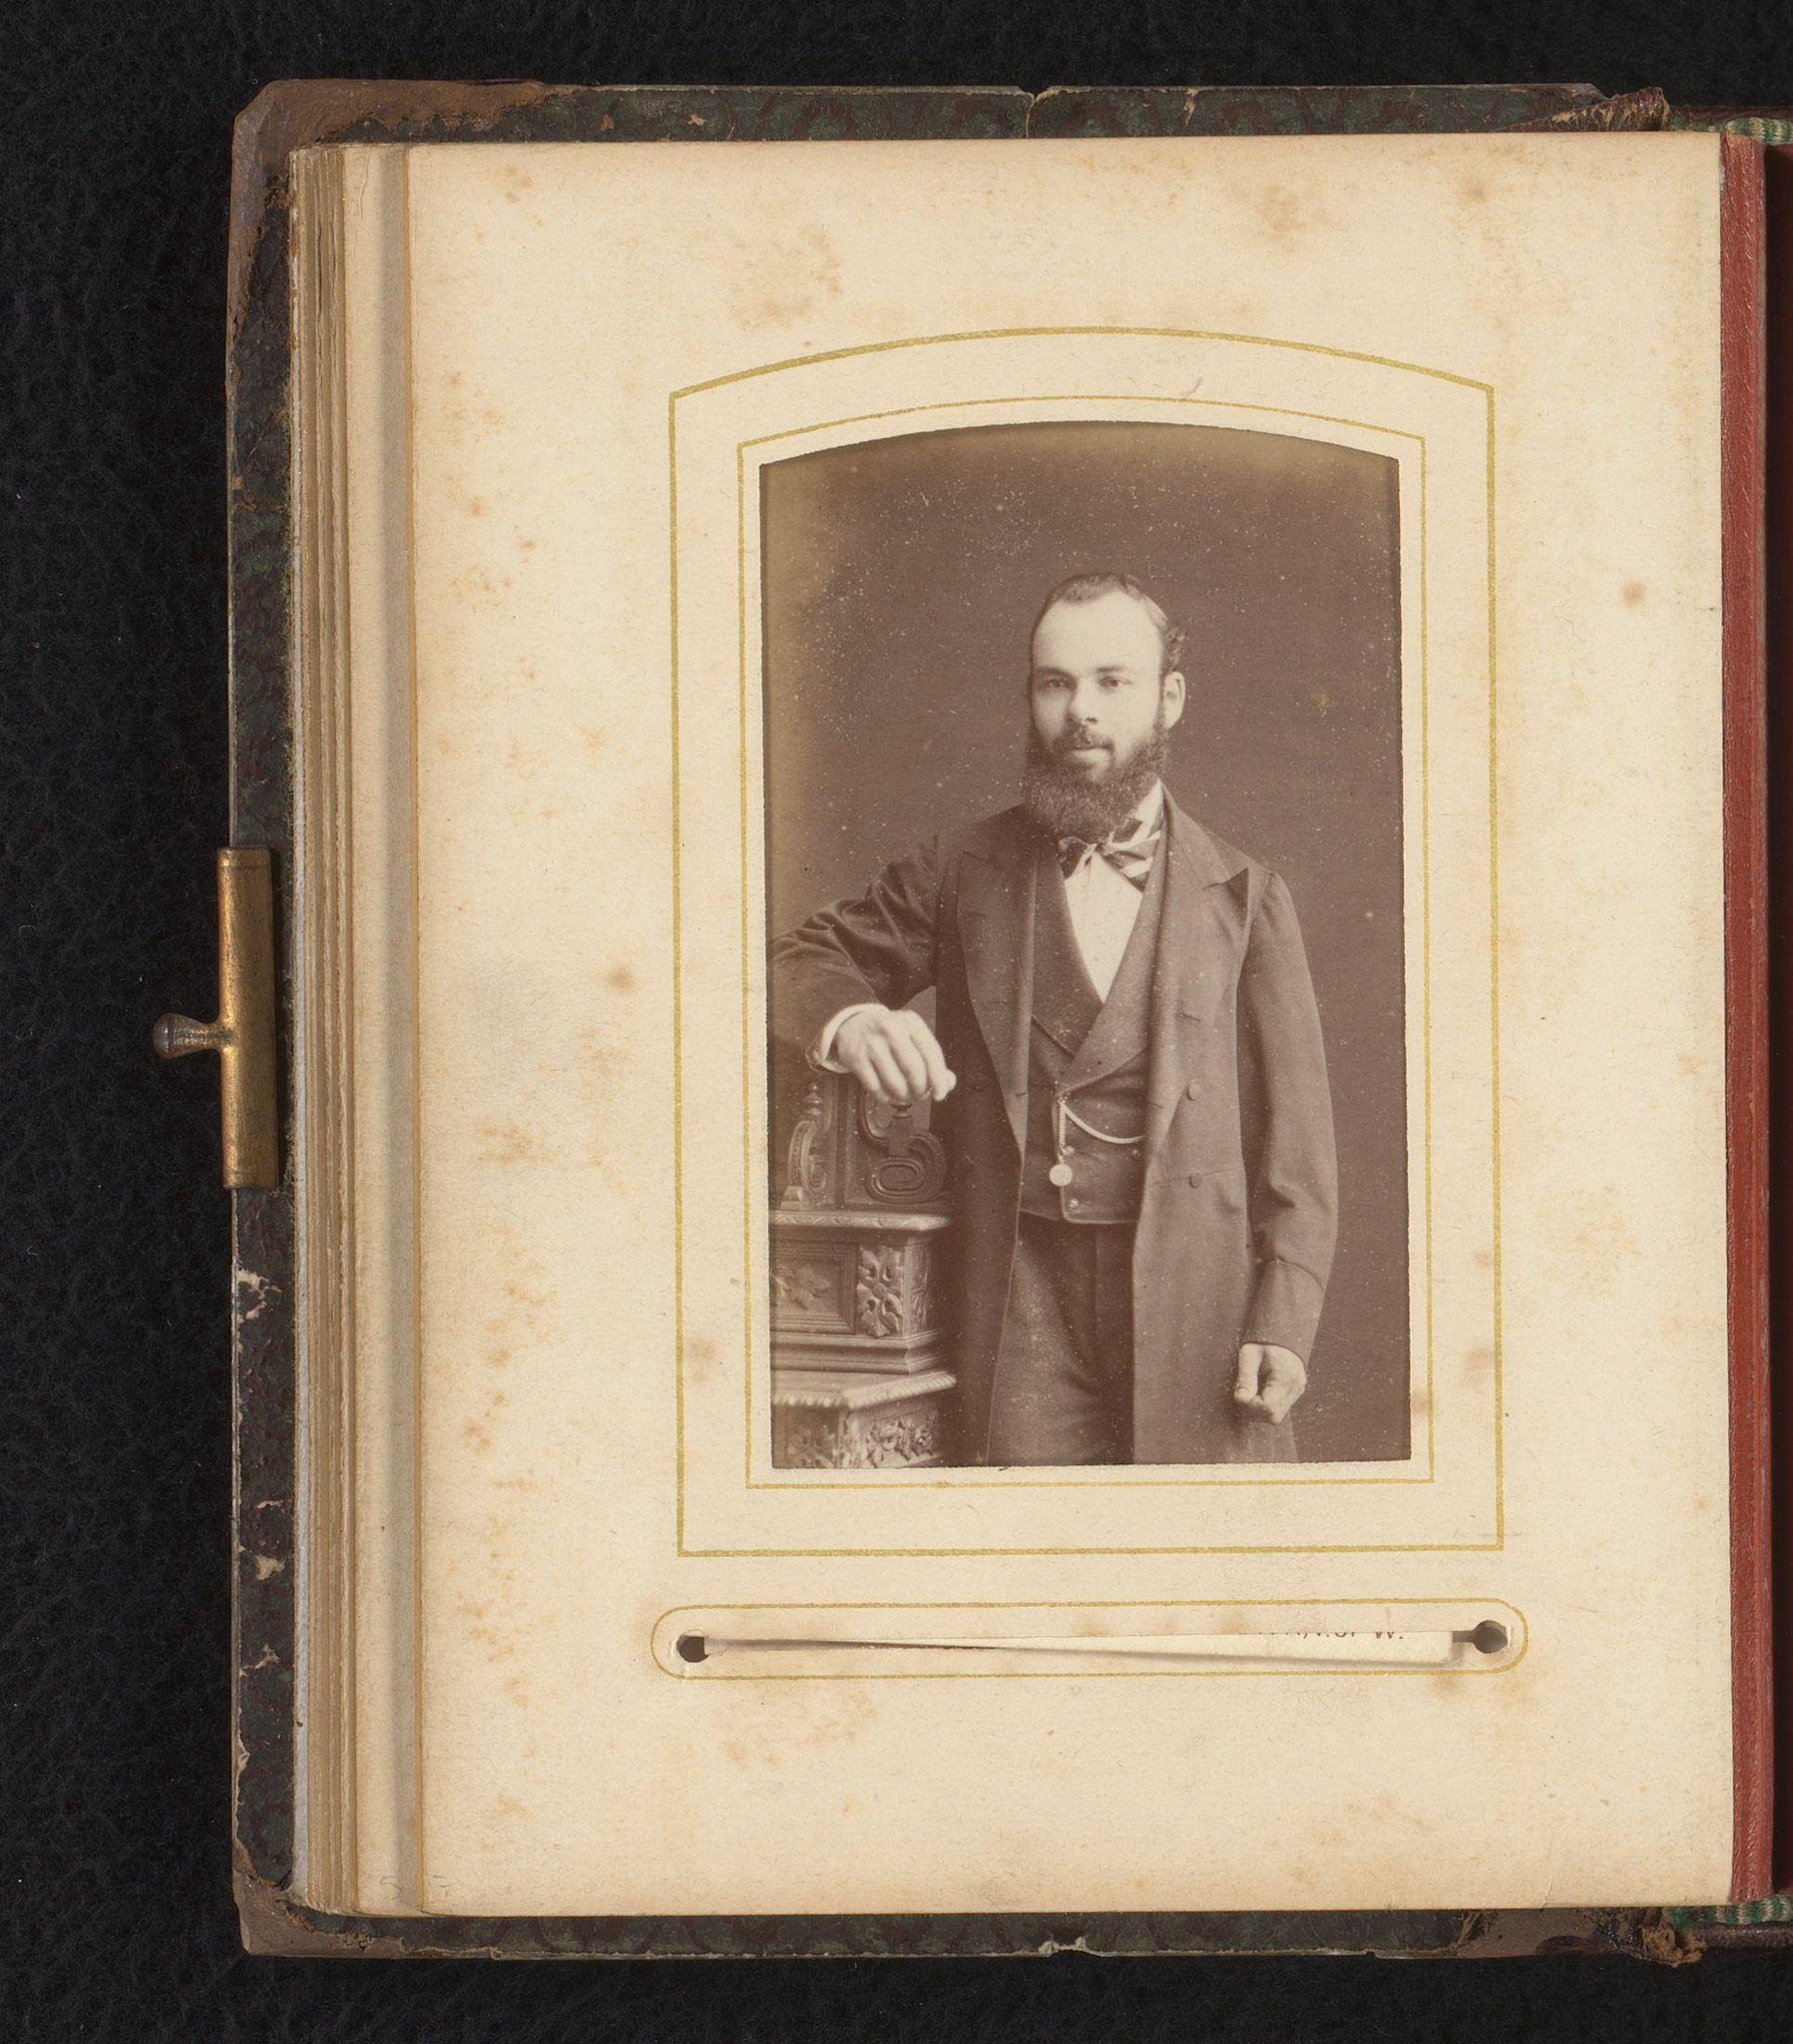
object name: carte de visite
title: Portret van een man met baard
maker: arthur nicholls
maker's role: fotograaf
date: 1860-1900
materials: cardboard, photographic support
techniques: albumen print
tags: adult man, historical persons, beard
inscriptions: inscription: ‘Artist & photographer/ Arthur Nicholls/ 5 Marine Terrace/ Sandown/ I. of W.’